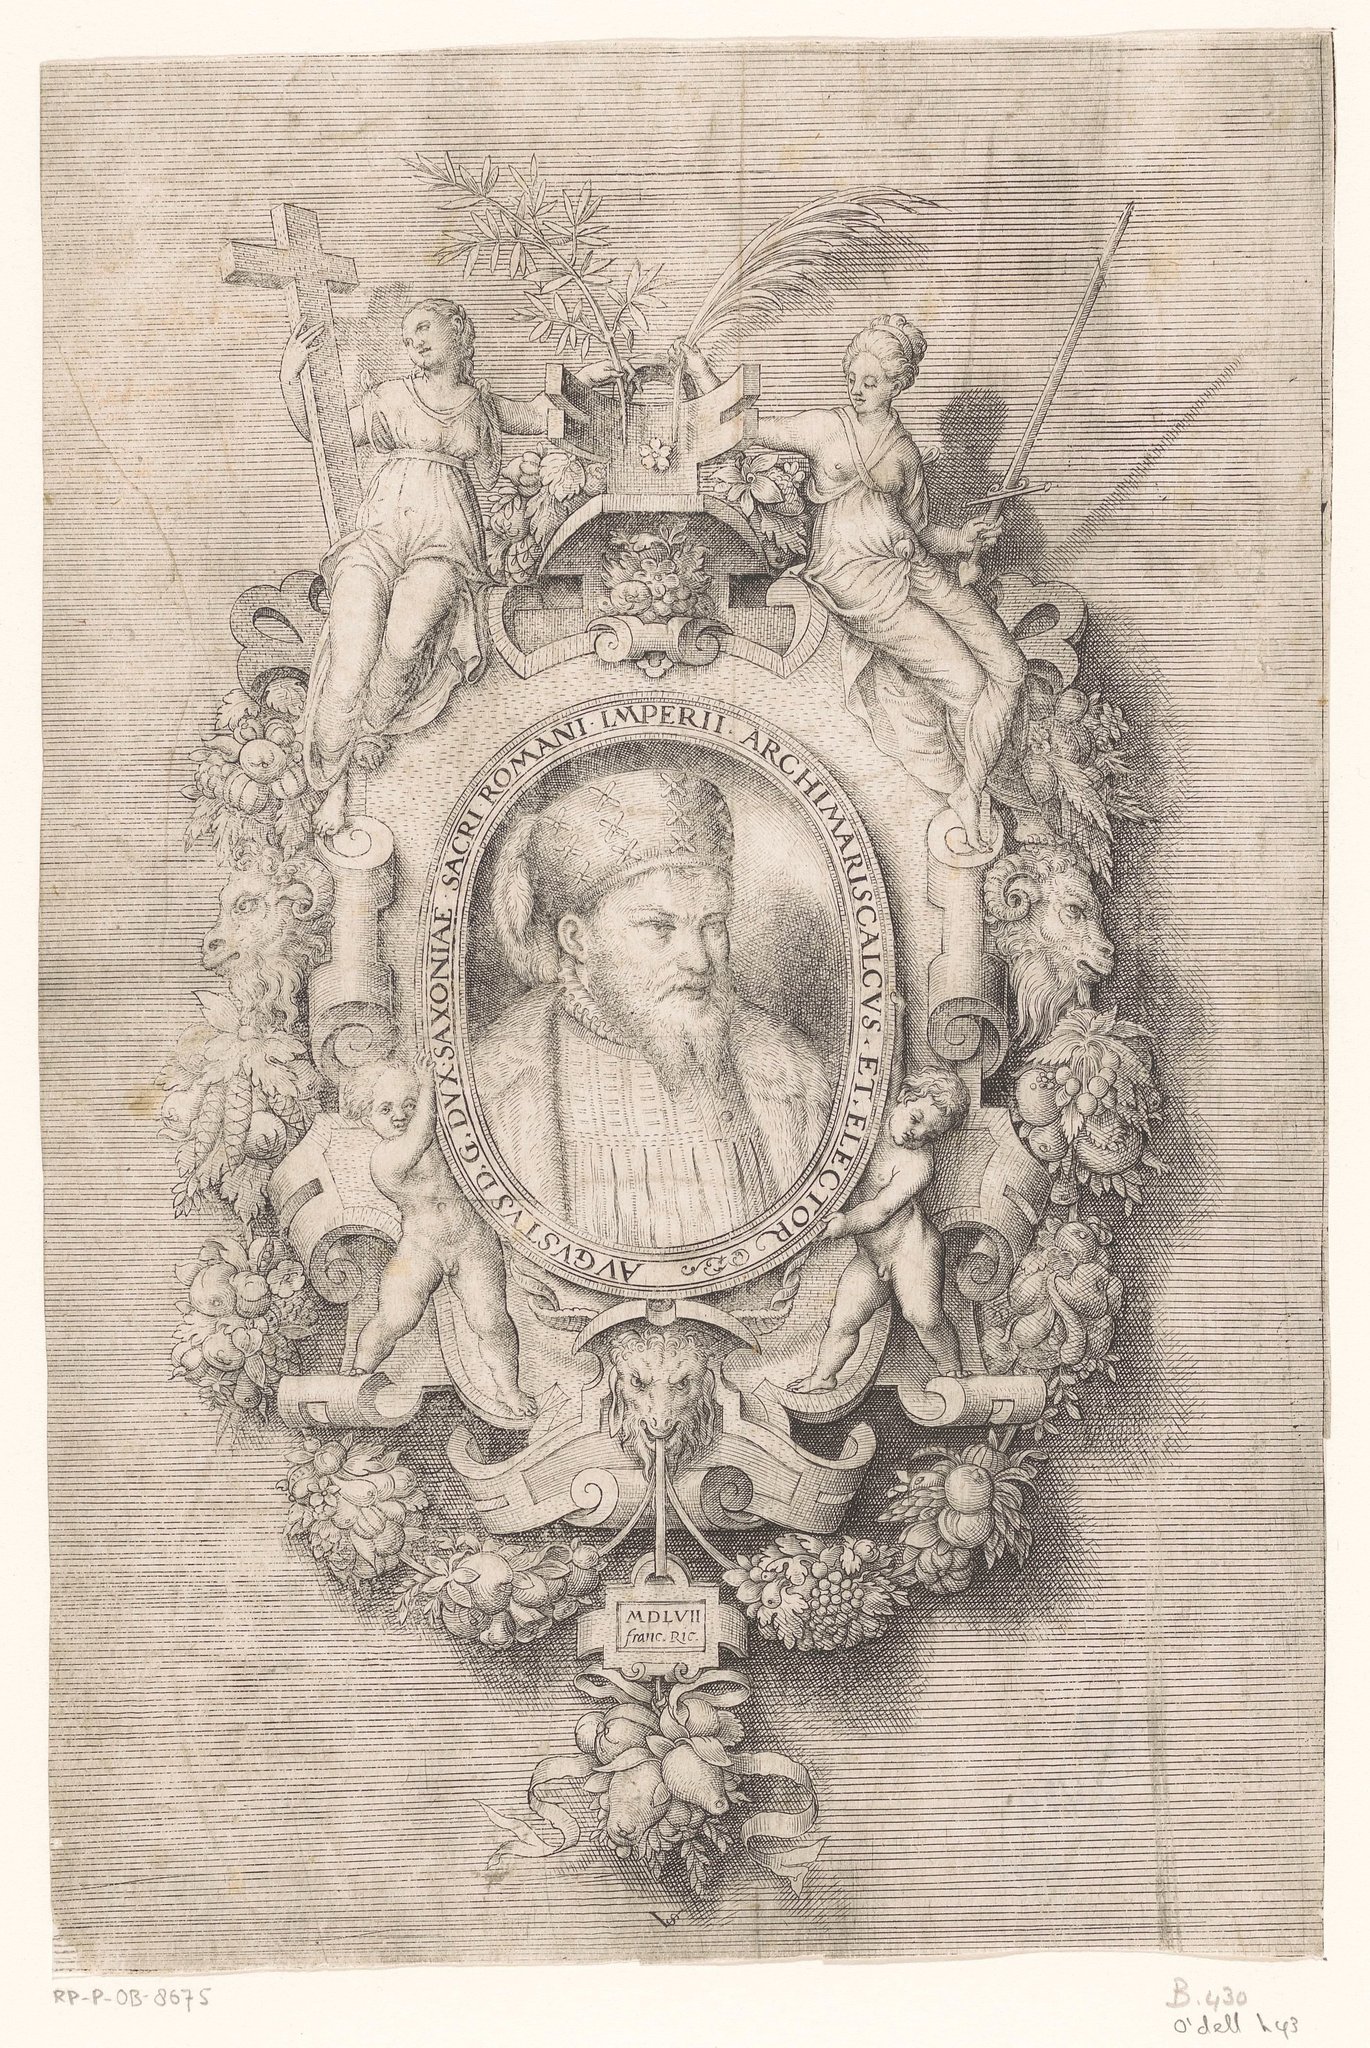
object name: print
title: Portret van Augustus, keurvorst van Saksen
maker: virgilius solis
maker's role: draughtsman, print maker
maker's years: 1514-1562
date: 1557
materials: paper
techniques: engraving, etching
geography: nuremberg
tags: fides (faith) as roman personification, scrollwork, strapwork ~ ornament, historical persons, justitia (justice) as roman personification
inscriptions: collector's mark: Lugt 2228, number: ‘166’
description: Prent gebruikt voor de publicatie: Luther, Martin. Biblia das ist die gantze hailige Schrifft verdeutschet durch D. Martin Lutter. Wittenberg: Hans Lufft, 1561.